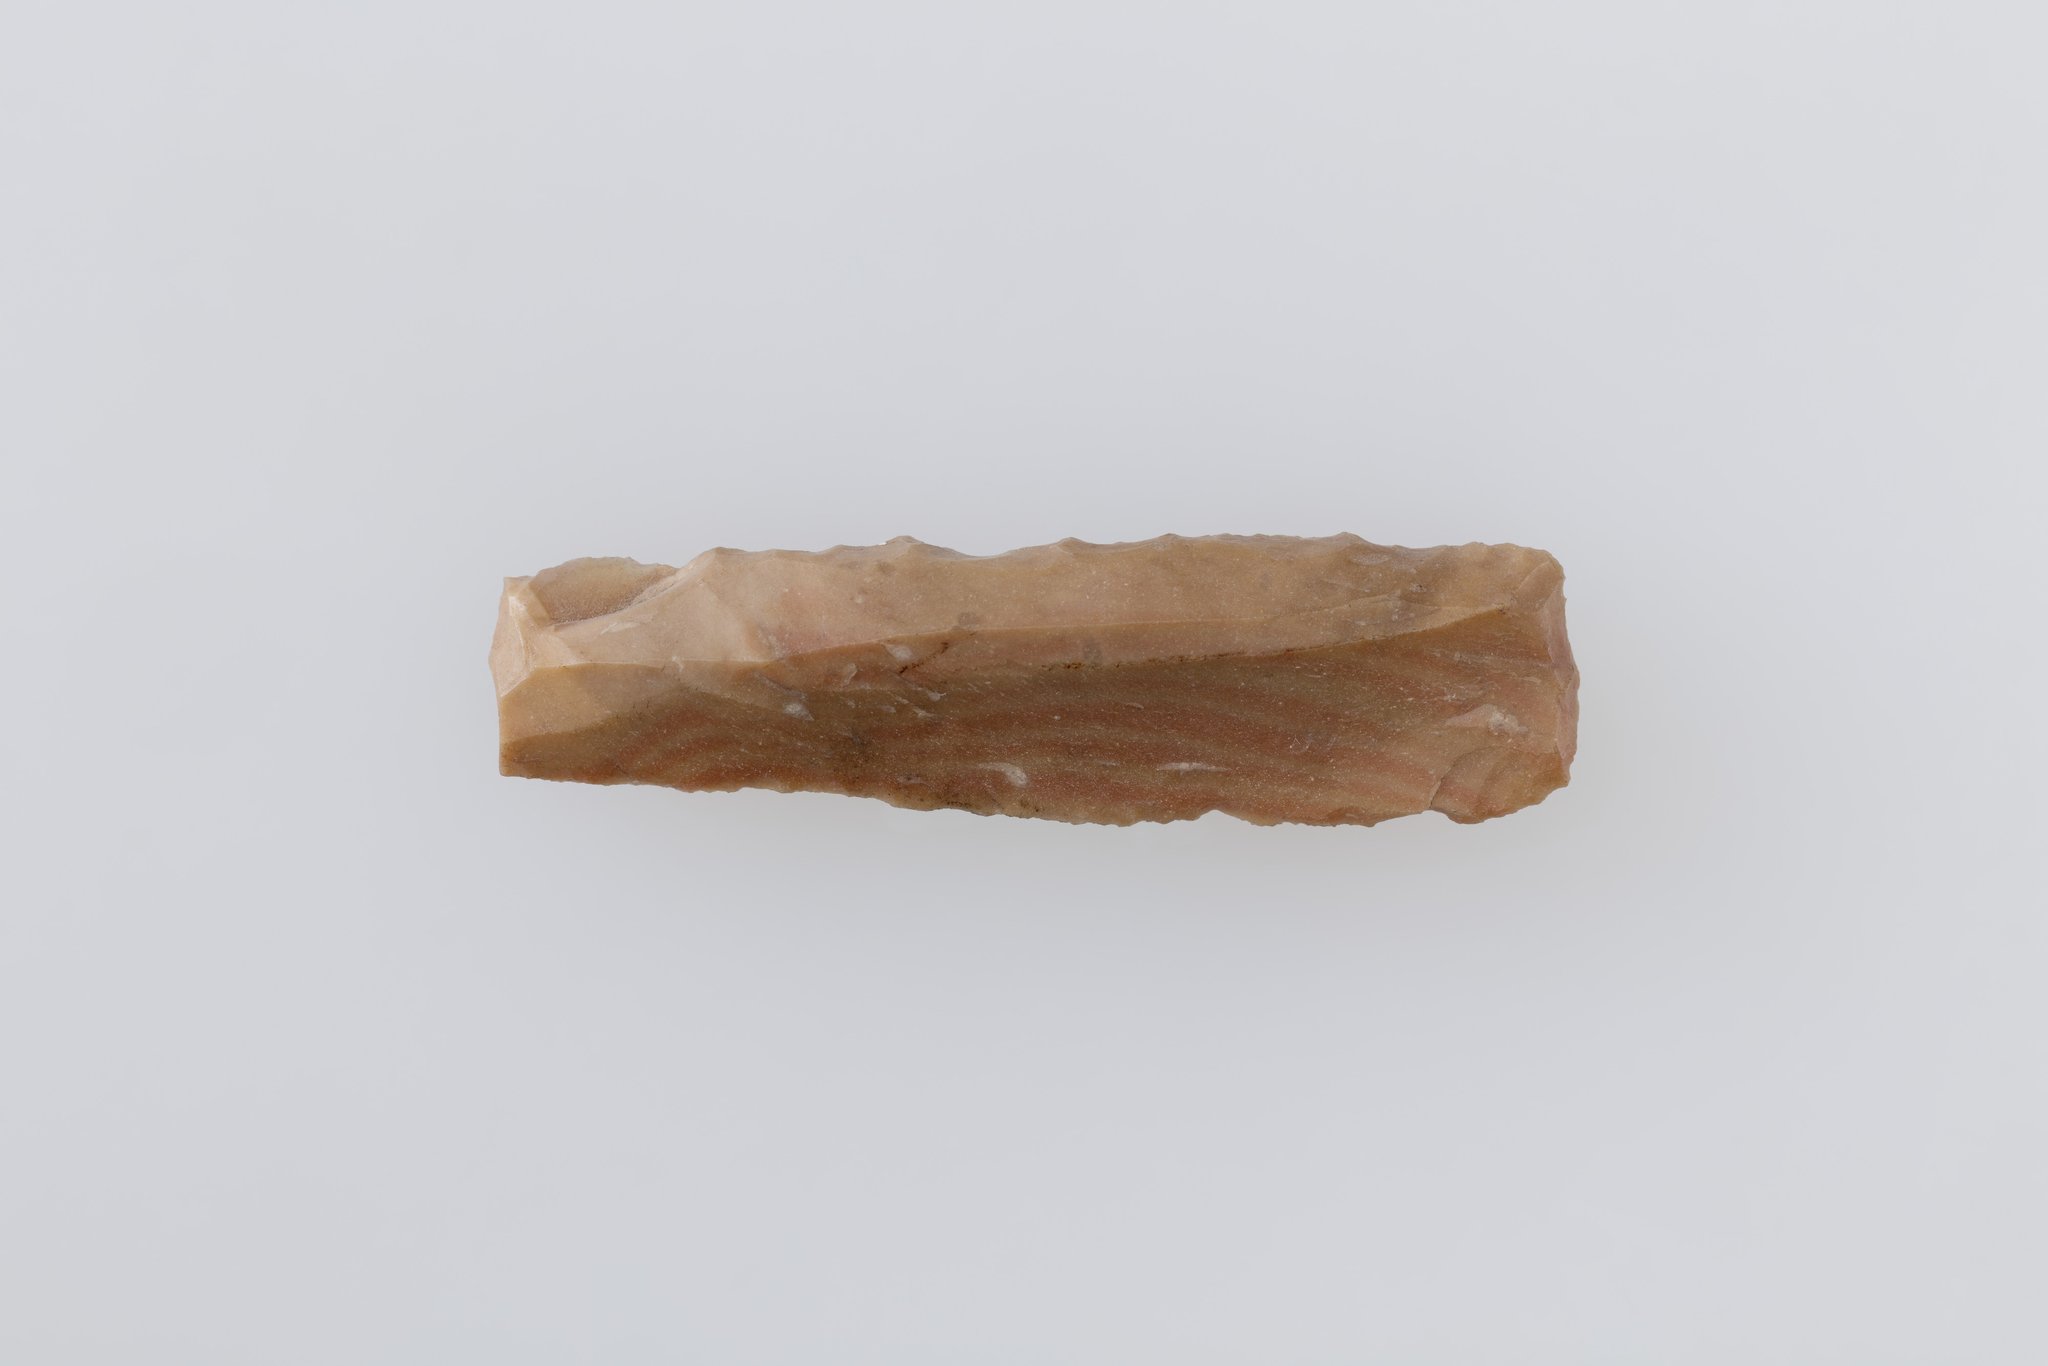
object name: tool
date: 3100-2649 BCE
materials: stone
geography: egypt